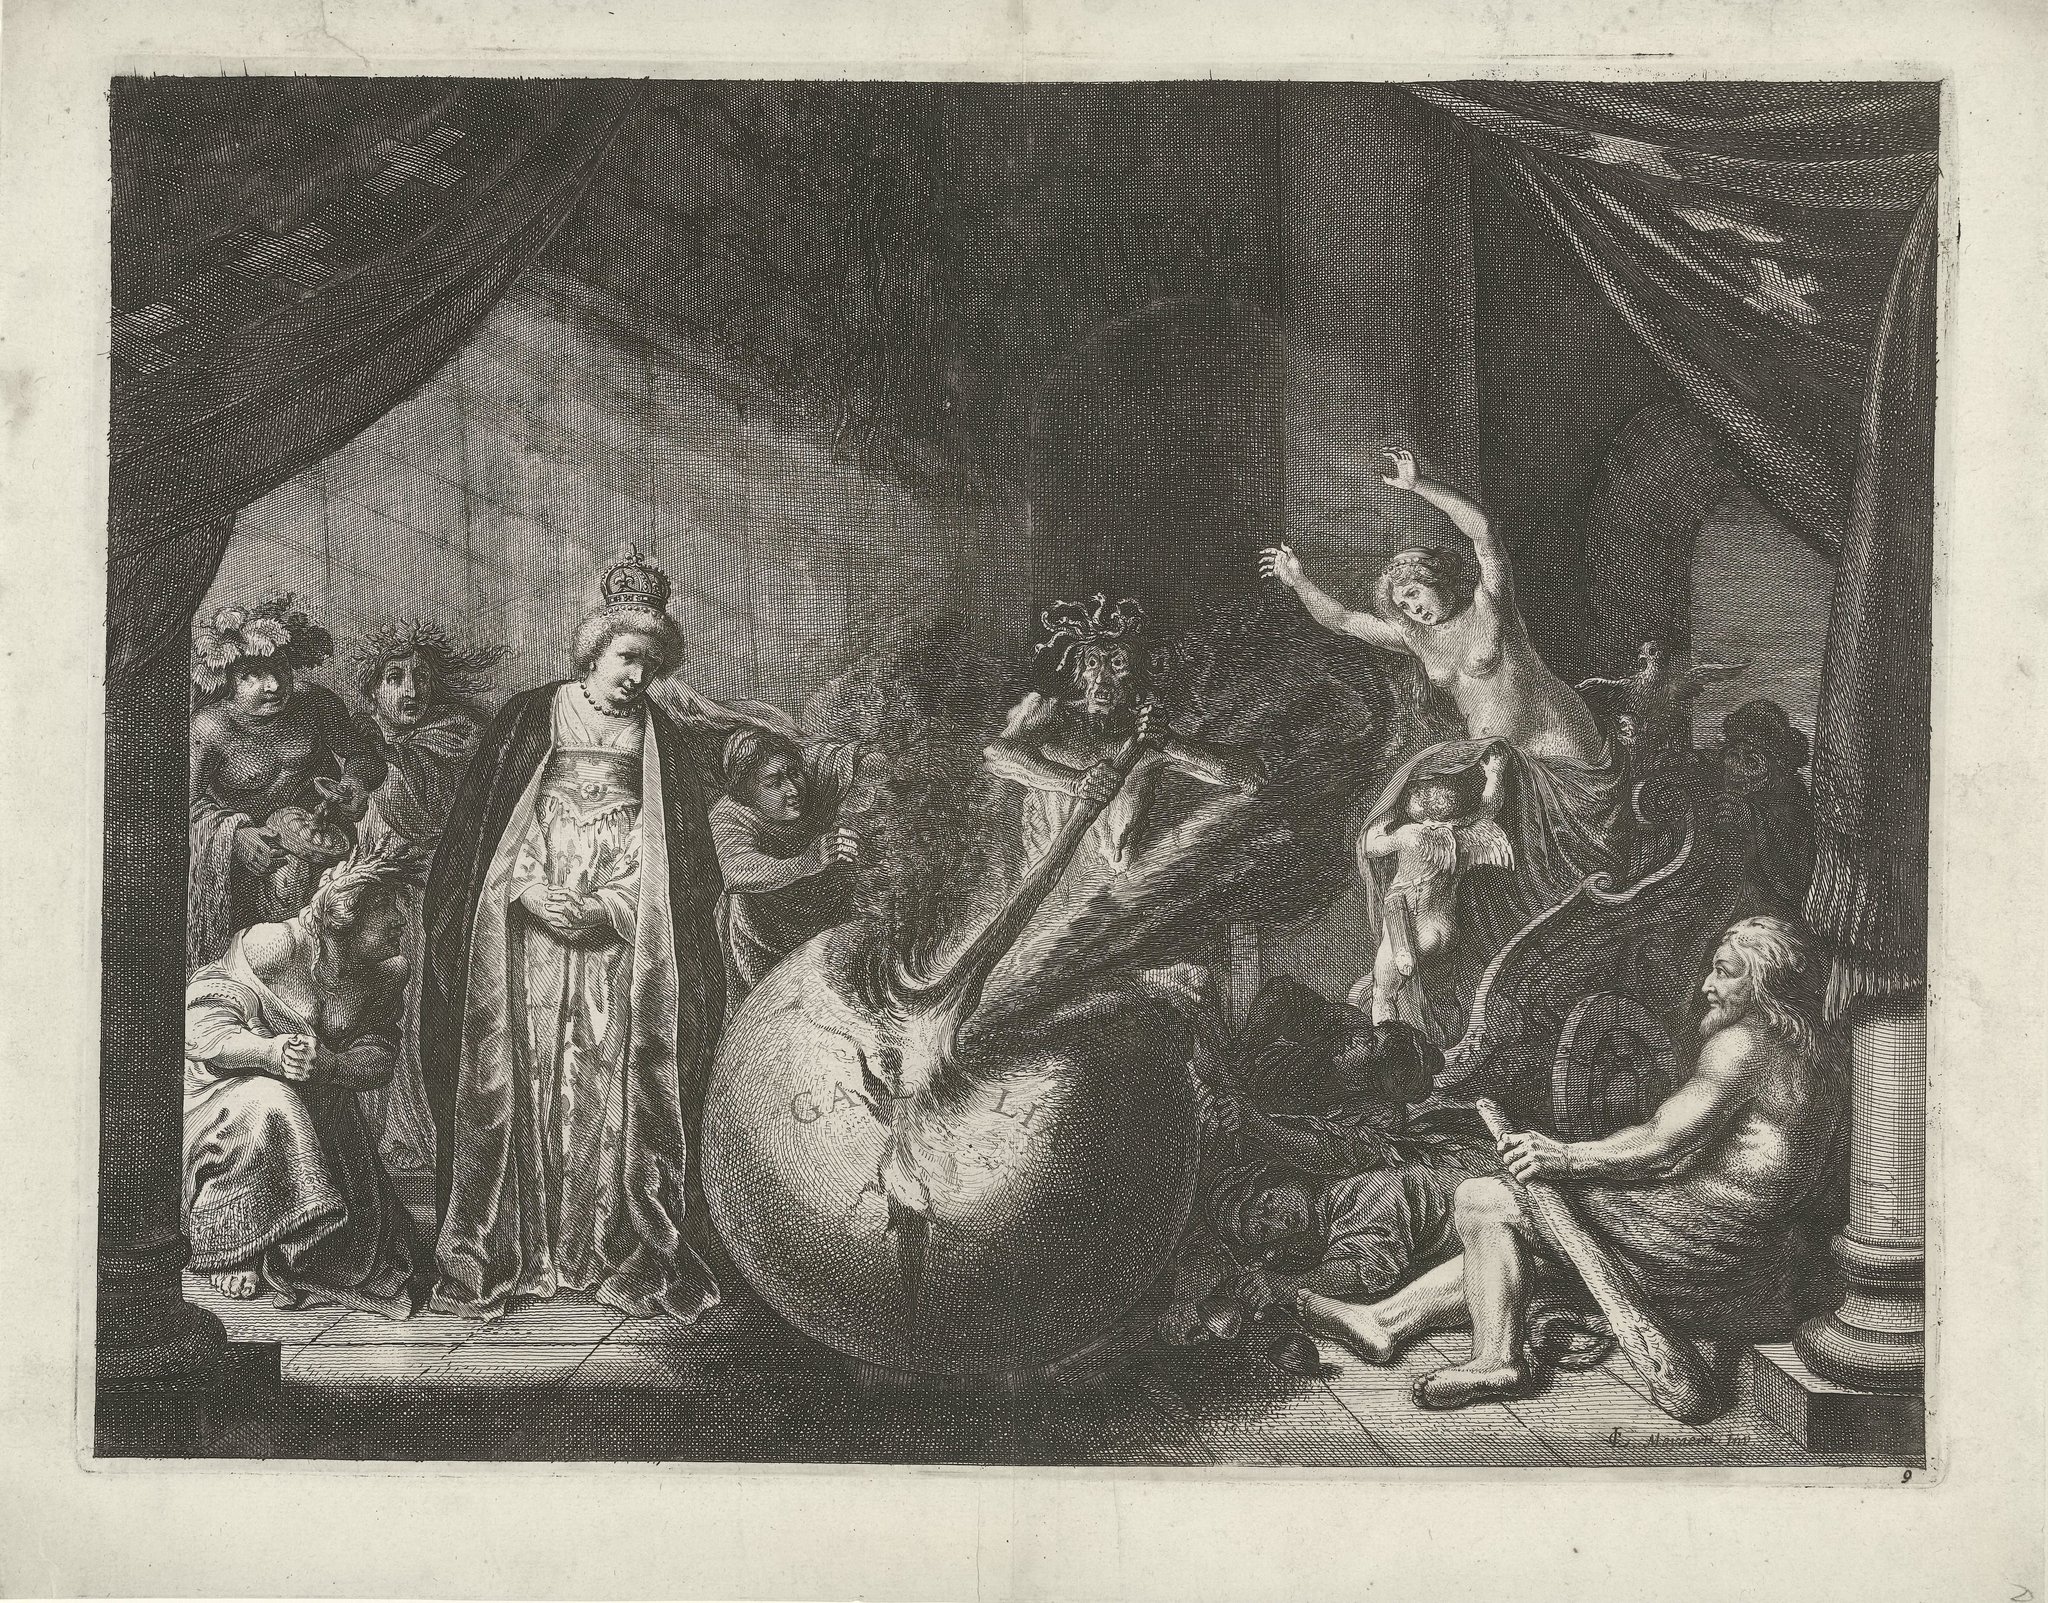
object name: book illustration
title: Franse maagd beweent de rampspoed van Frankrijk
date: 1638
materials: paper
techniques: engraving, etching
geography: amsterdam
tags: cologne, print maker, maria de' medici, 'tableau vivant', personifications of countries, nations, states, districts, etc., symbols, allegories of peace, 'pax'; 'pace' (ripa), triumphal entry and public reception, pageant, 'entrée solennelle', 'joyeuse entrée', justice; 'forza alla giustitia sottoposta', 'giustitia', 'giustitia retta', 'giustitia rigorosa', 'impietà e violenza soggetta alla giustitia' (ripa), (story of) venus (aphrodite), amsterdam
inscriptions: collector's mark: Lugt 240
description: Prent ook gebruikt in:* Baerle, Caspar van. Medicea hospes, sive descriptio publicae gratulationis, qua Serenissimam, Augustissimamque Reginam, Mariam de Medicis (…). Amsterdam: Johannes en Cornelis Willemsz. Blaeu, 1638. En in: Baerle, Caspar van. Marie de Medicis, entrant dans Amsterdam : ou, histoire de la reception faicte à la Reyne Mere du Roy tres-Chrestien (…). Amsterdam: Johannes en Cornelis Willemsz. Blaeu, 1638. En in: Baerle, Caspar van en Joost van den Vondel. Blyde inkomst der allerdoorluchtighste koninginne, Maria de Medicis t' Amsterdam. Vertaelt uit het Latijn (…). Amsterdam: Johannes en Cornelis Willemsz. Blaeu, 1639. * Doorgaans zijn de prenten in de bovengenoemde publicaties rechtsonder genummerd (van de huidige prent is dat de derde bekende staat). Maar er zijn ook exemplaren waarin eerdere, ongenummerde, staten van de prenten (van de huidige prent de eerste en tweede bekende staat) zijn ingebonden.